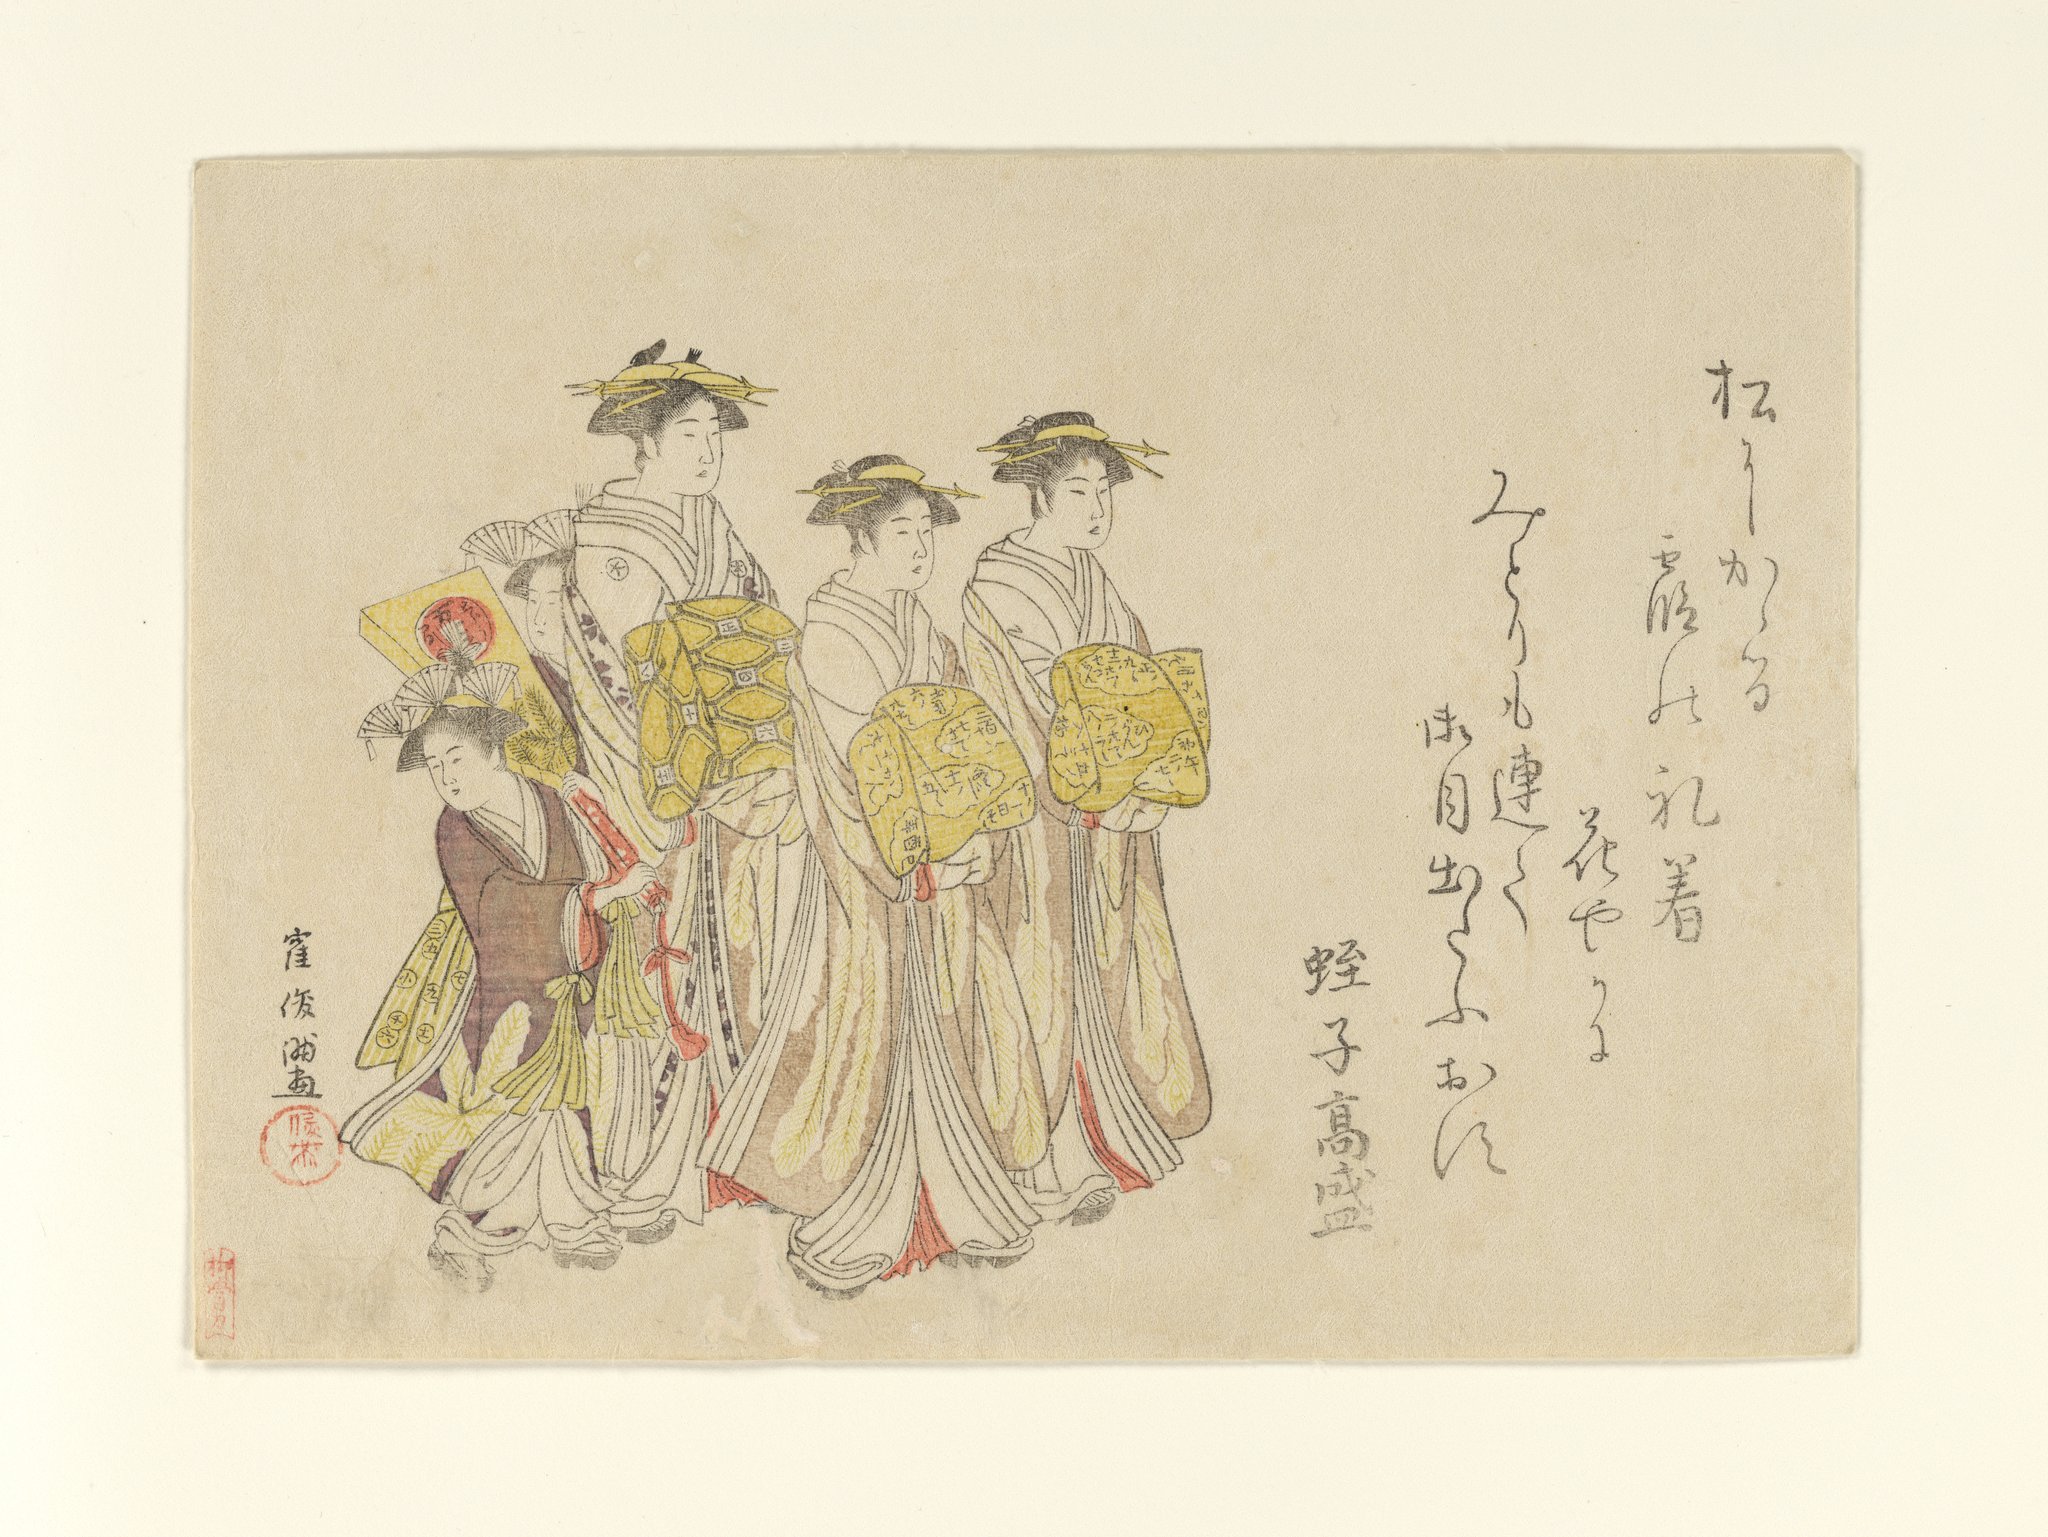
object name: print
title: Procession of a Courtesan with Her Four Attendants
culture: japanese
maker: kubo shunman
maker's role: artist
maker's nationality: japanese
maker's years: 1757-1820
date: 1789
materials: ink, paper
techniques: surimono, woodblock print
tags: women